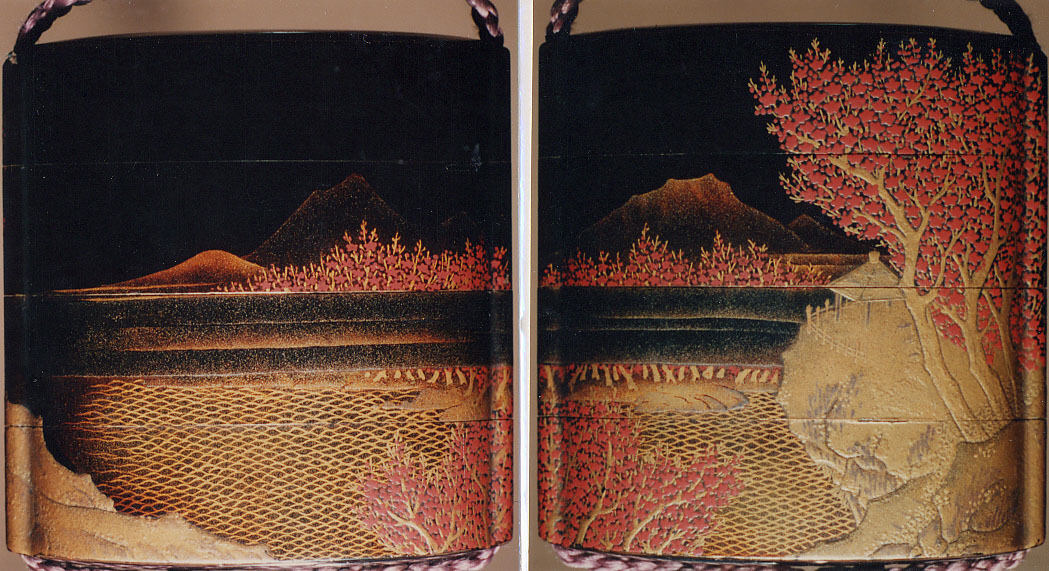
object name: inrō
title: Case (Inrō) with Design of Pavilion on Rocks above Waves, with Flowering Plum Trees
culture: japanese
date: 1701-1900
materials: gold, lacquer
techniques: fundame, hiramakie, roiro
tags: flowers,mountains,trees